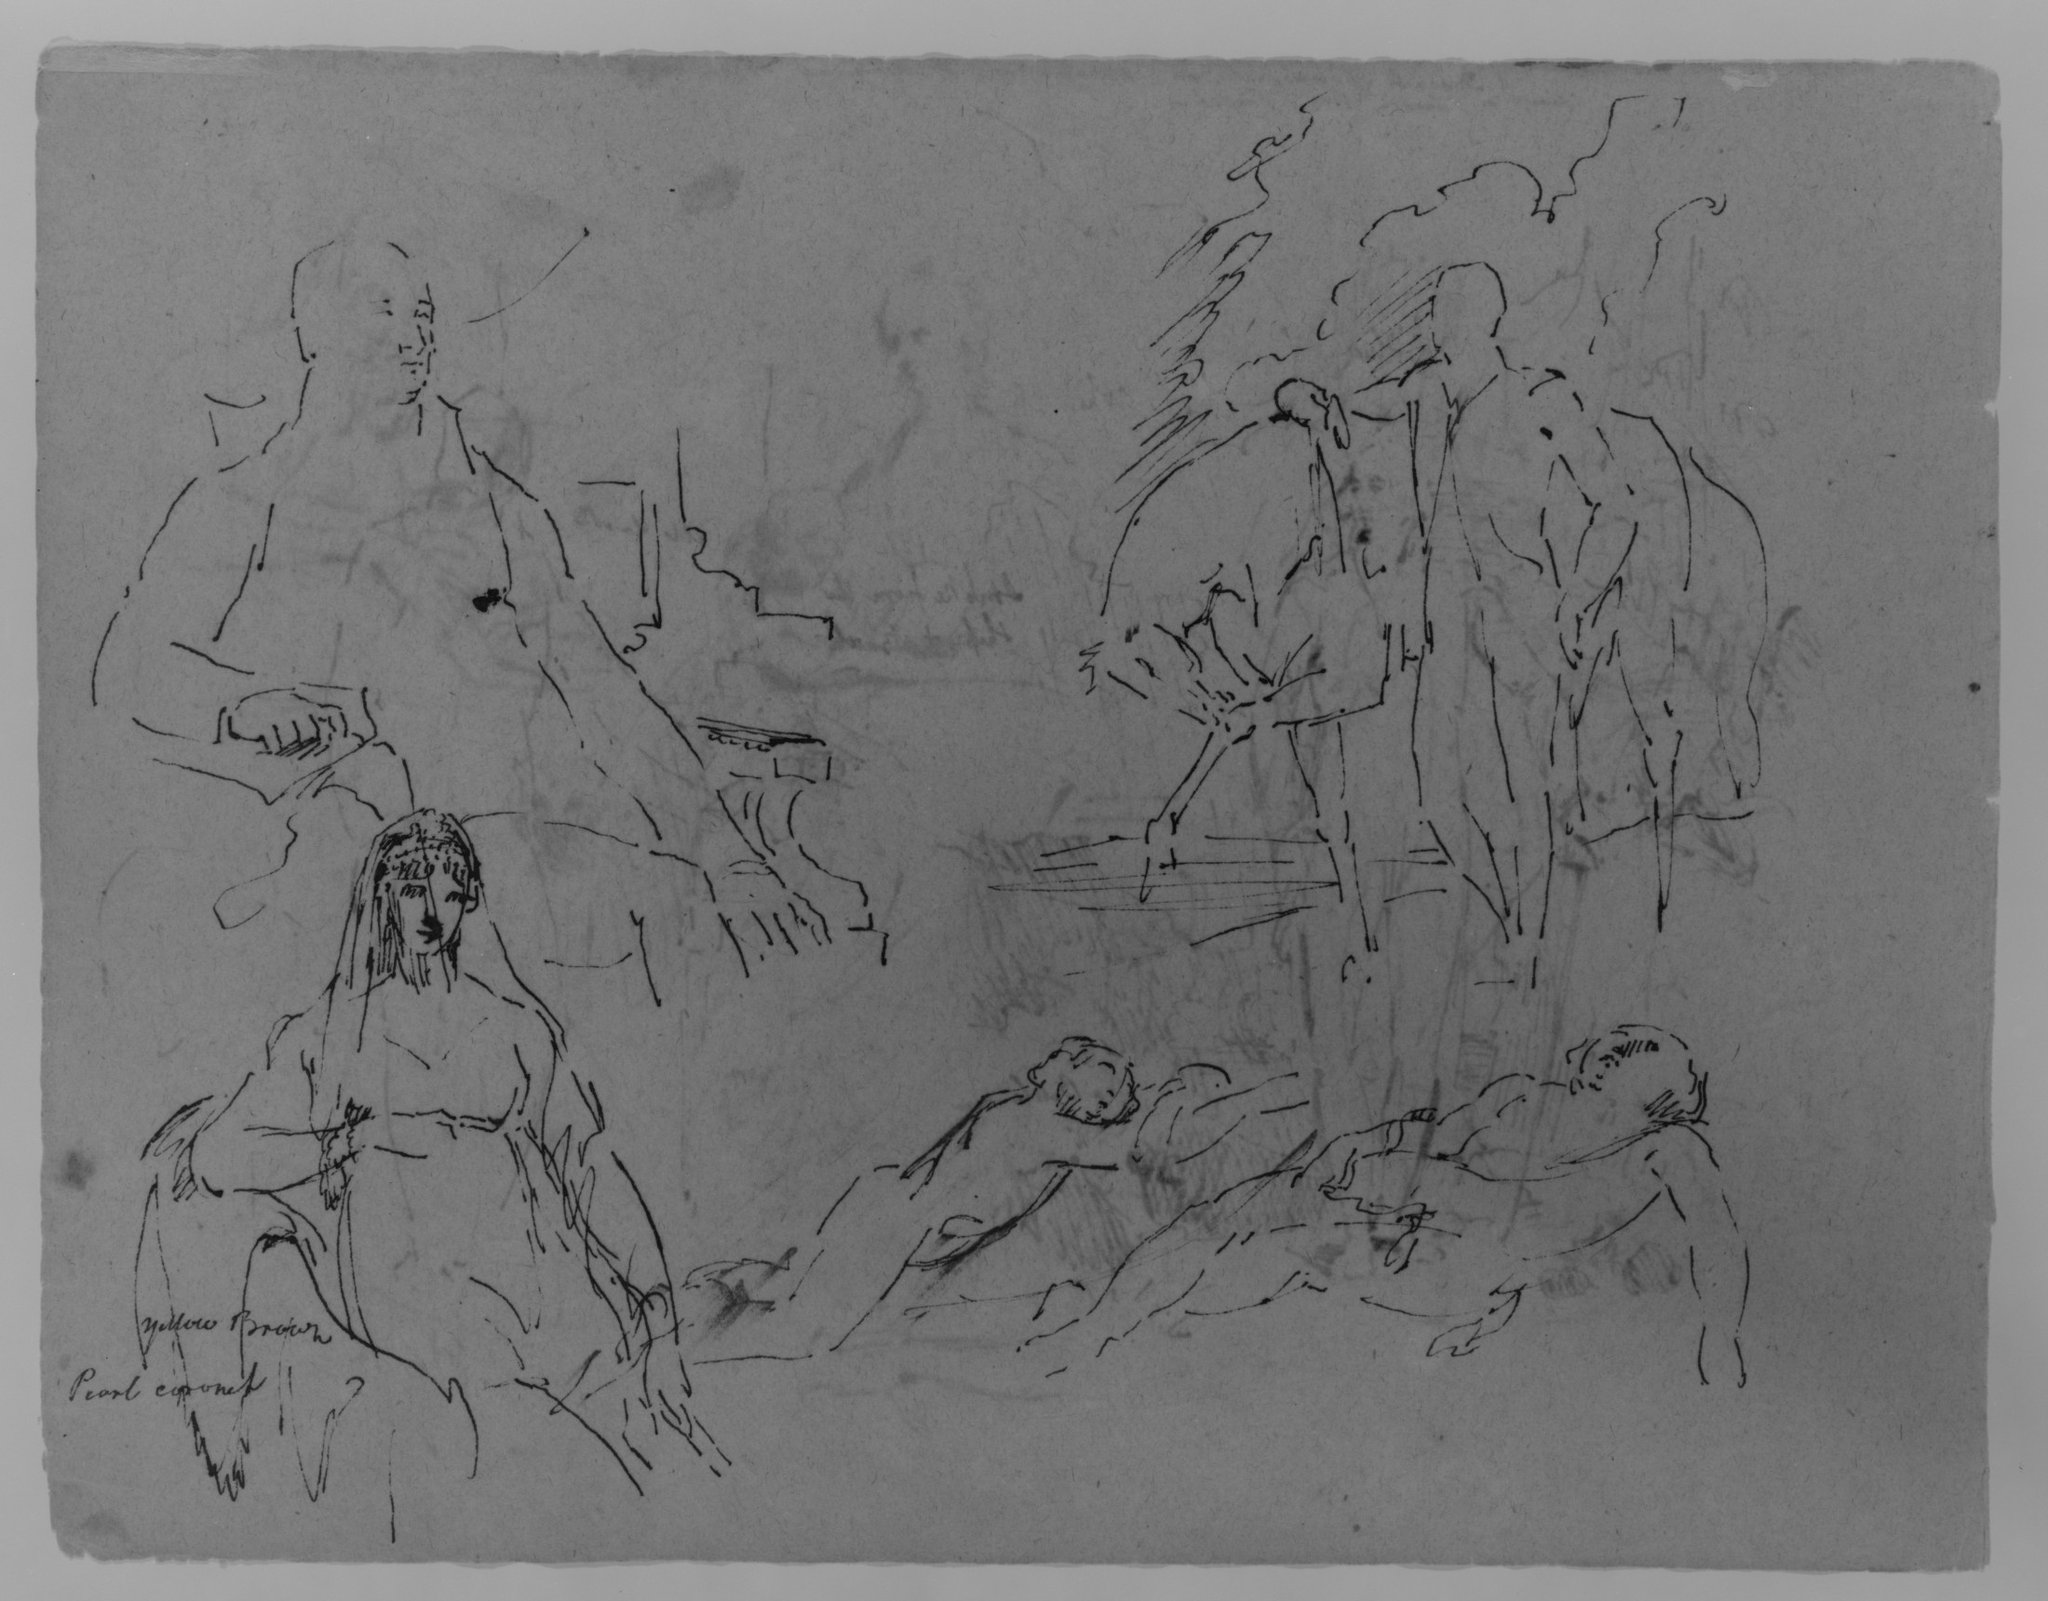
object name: drawing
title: (From Sketchbook)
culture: american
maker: thomas sully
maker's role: artist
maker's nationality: american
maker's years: 1783-1872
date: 1810-1820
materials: ink, paper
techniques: wash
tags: men,women,horses